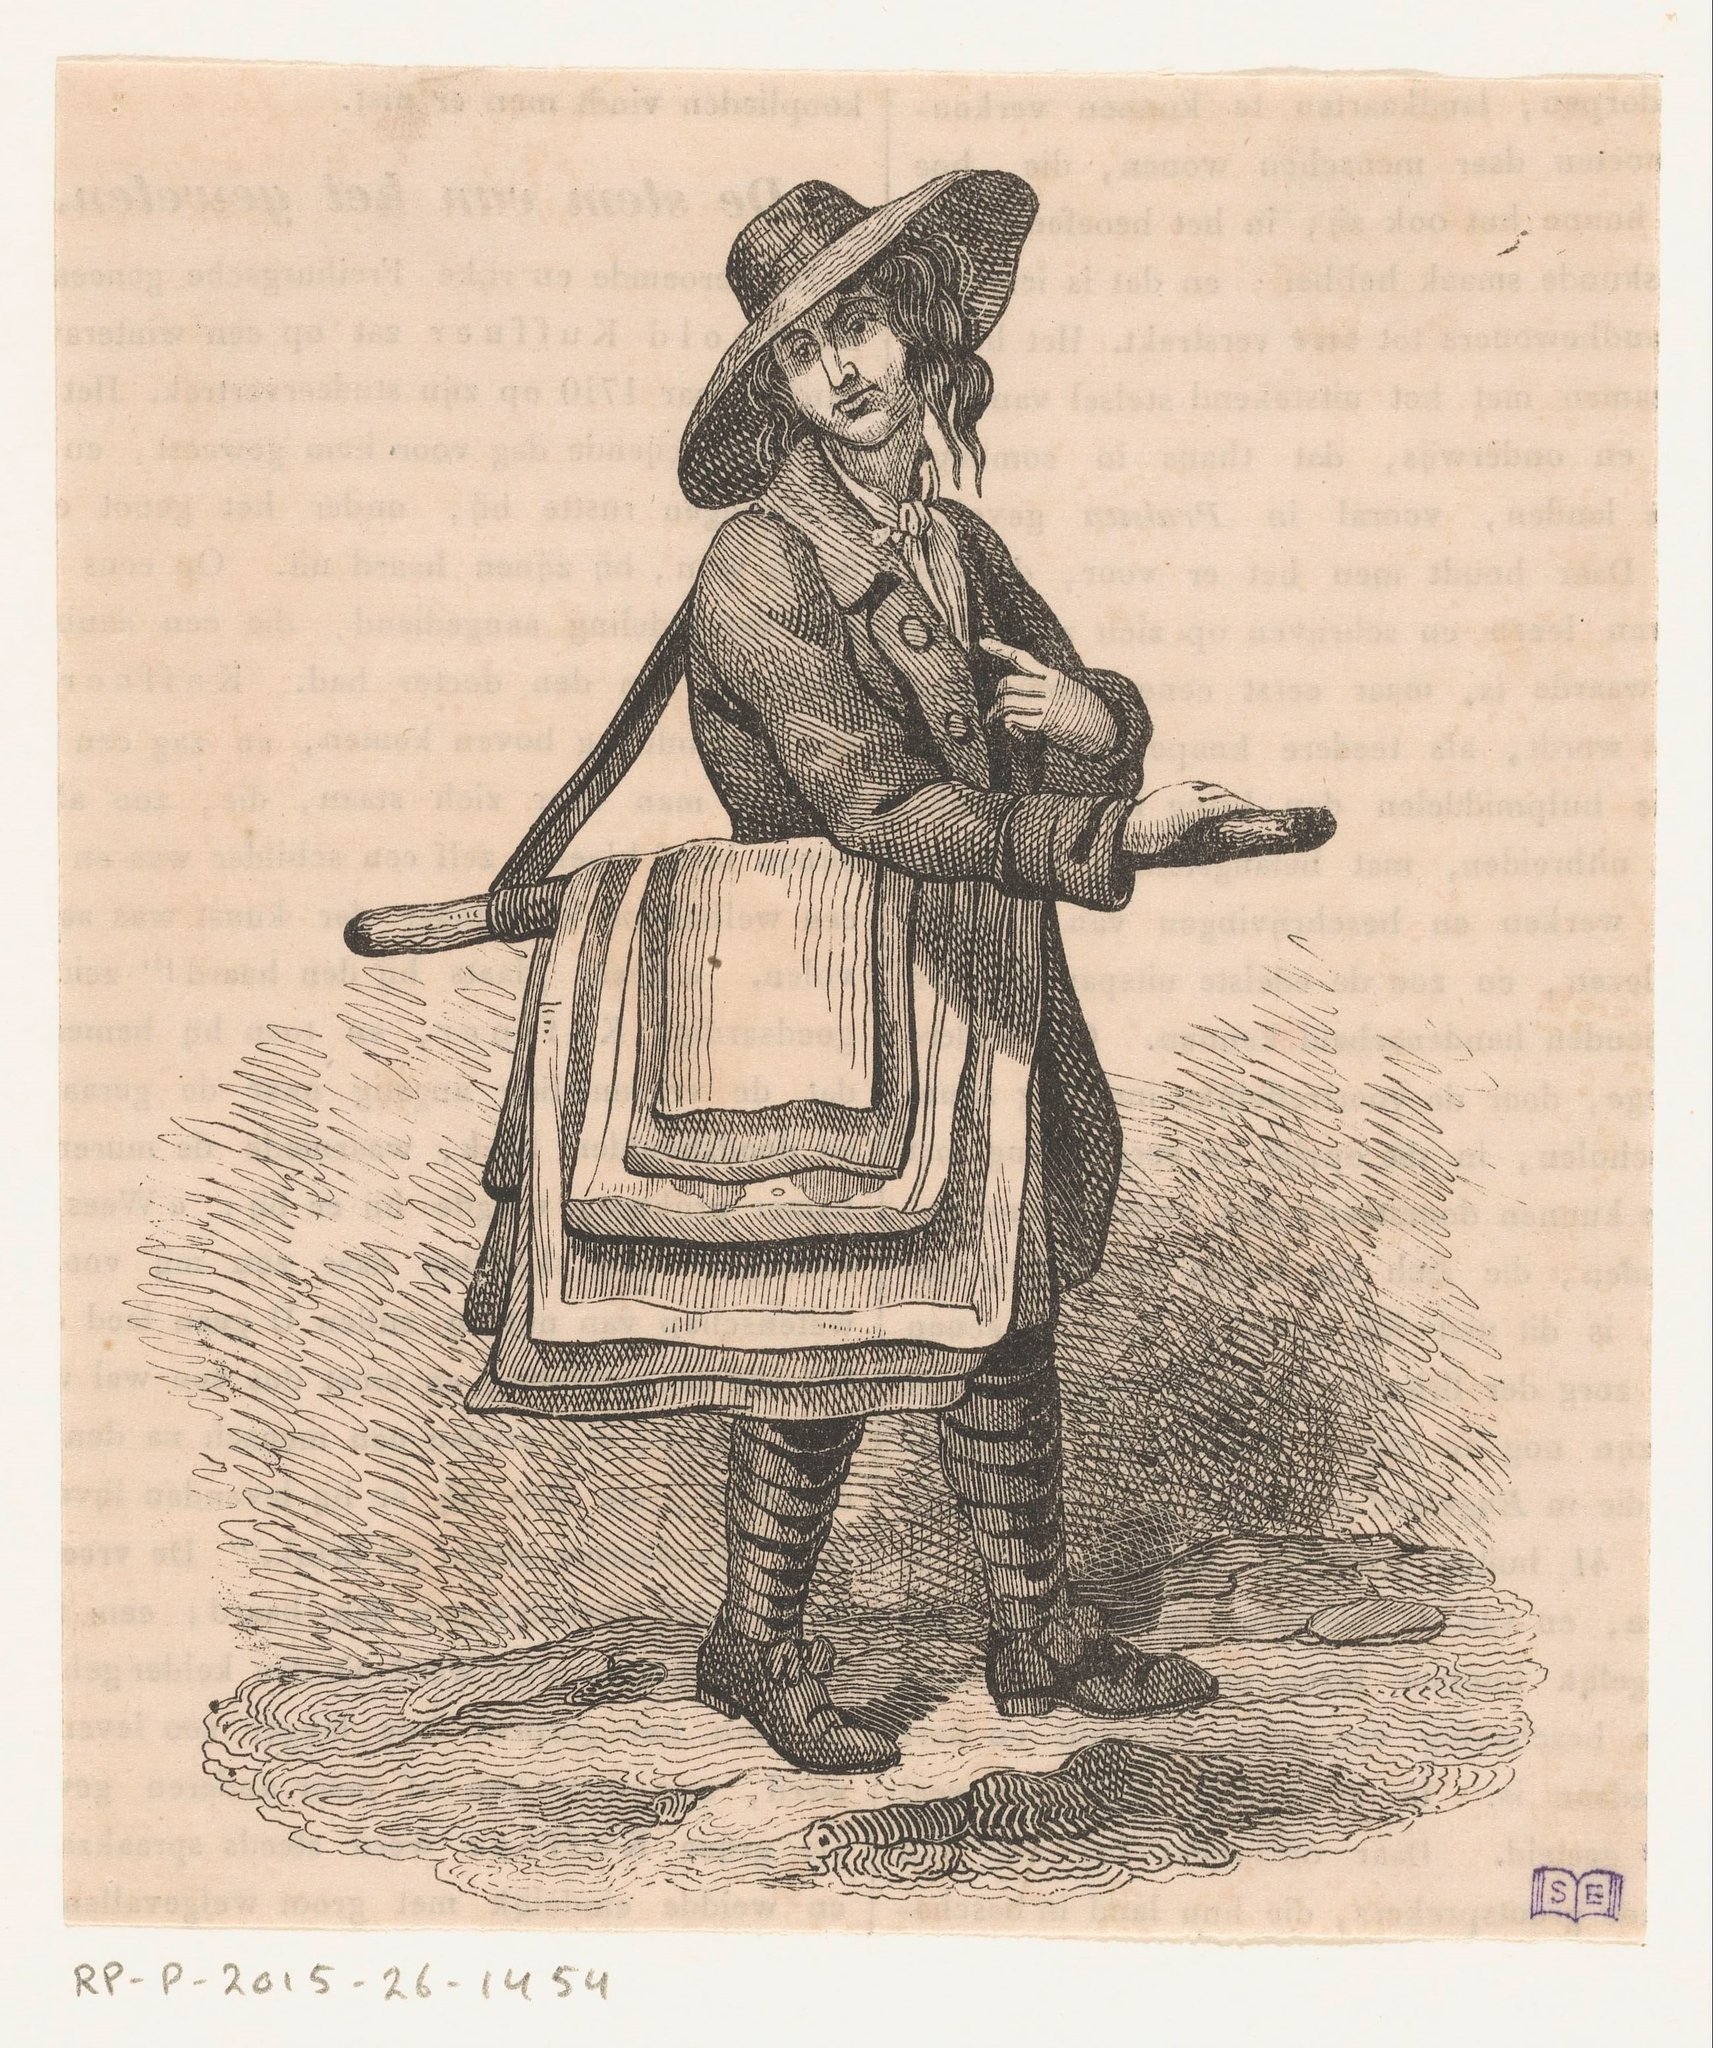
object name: print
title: Rondreizende verkoper van landkaarten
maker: Anonymous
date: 1839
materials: paper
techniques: letterpress printing, engraving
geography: the hague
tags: maps, atlases, book, street-trader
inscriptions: collector's mark: Lugt 4780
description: Prent afkomstig uit: Hollandsch Penning-Magazijn voor de Jeugd. Den Haag: S. de Visser en Zoon, 1839, p. 413.